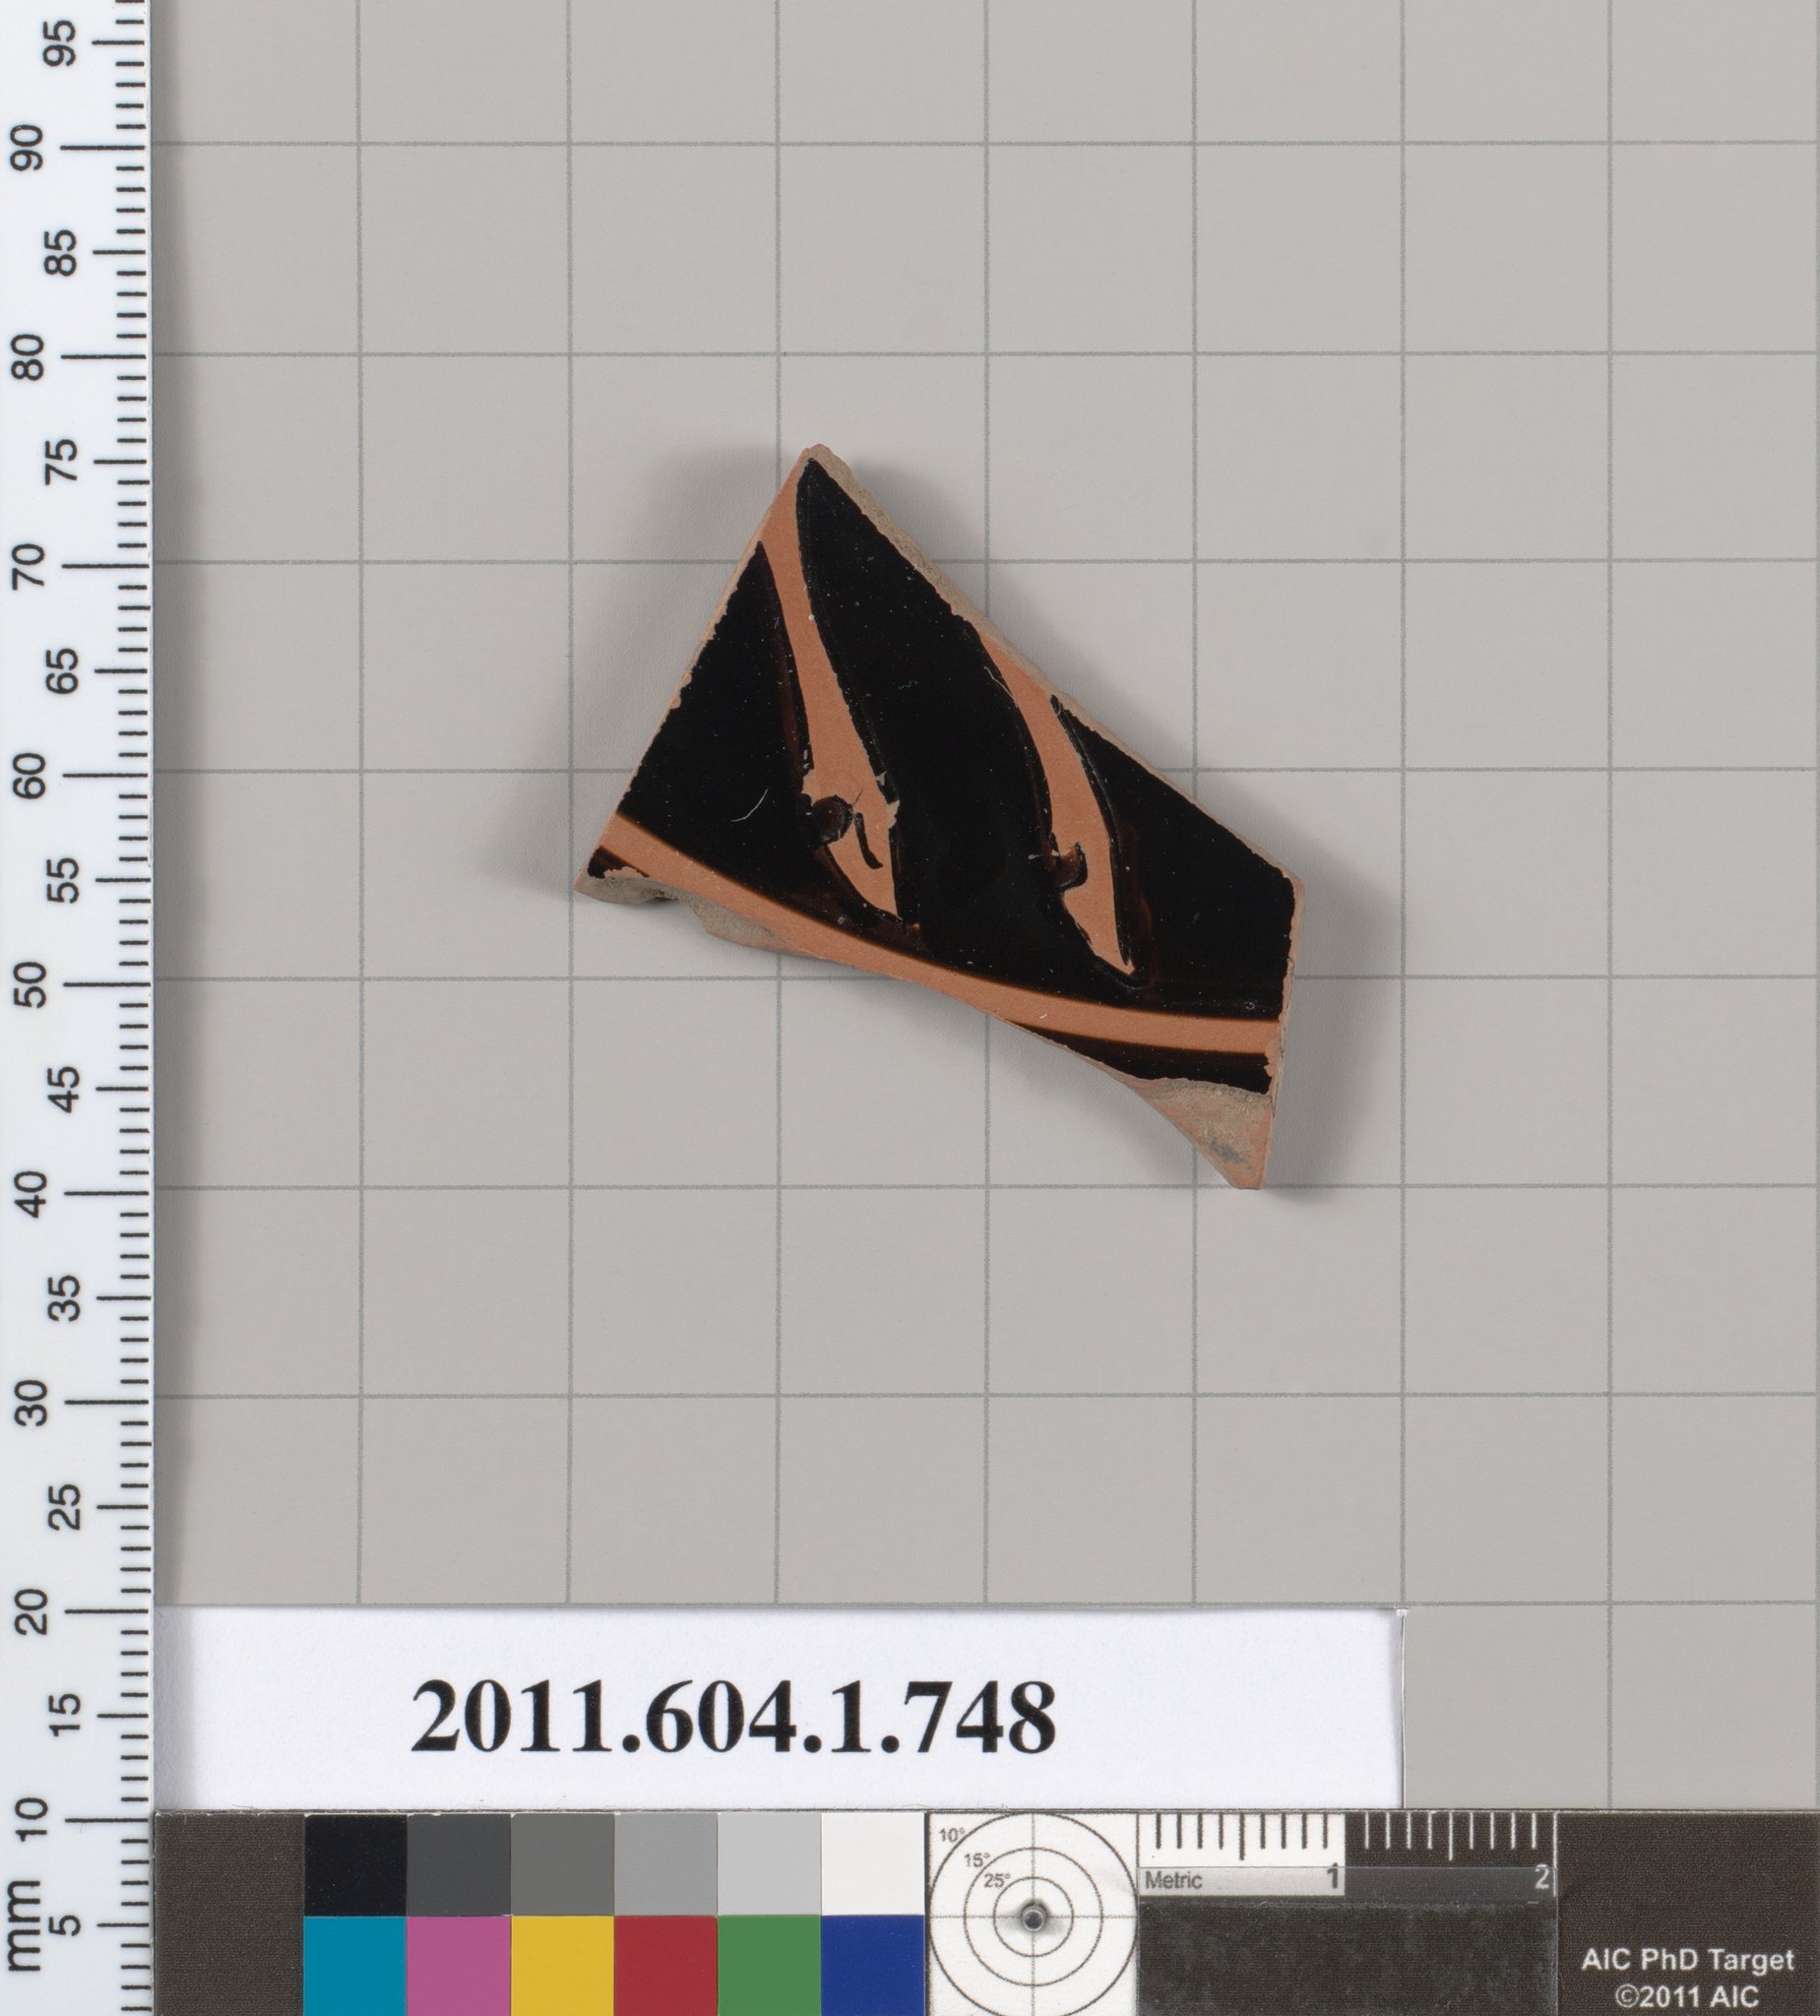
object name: kylix fragment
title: Terracotta fragment of a kylix (drinking cup)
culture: greek, attic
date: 490-480 BCE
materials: terracotta